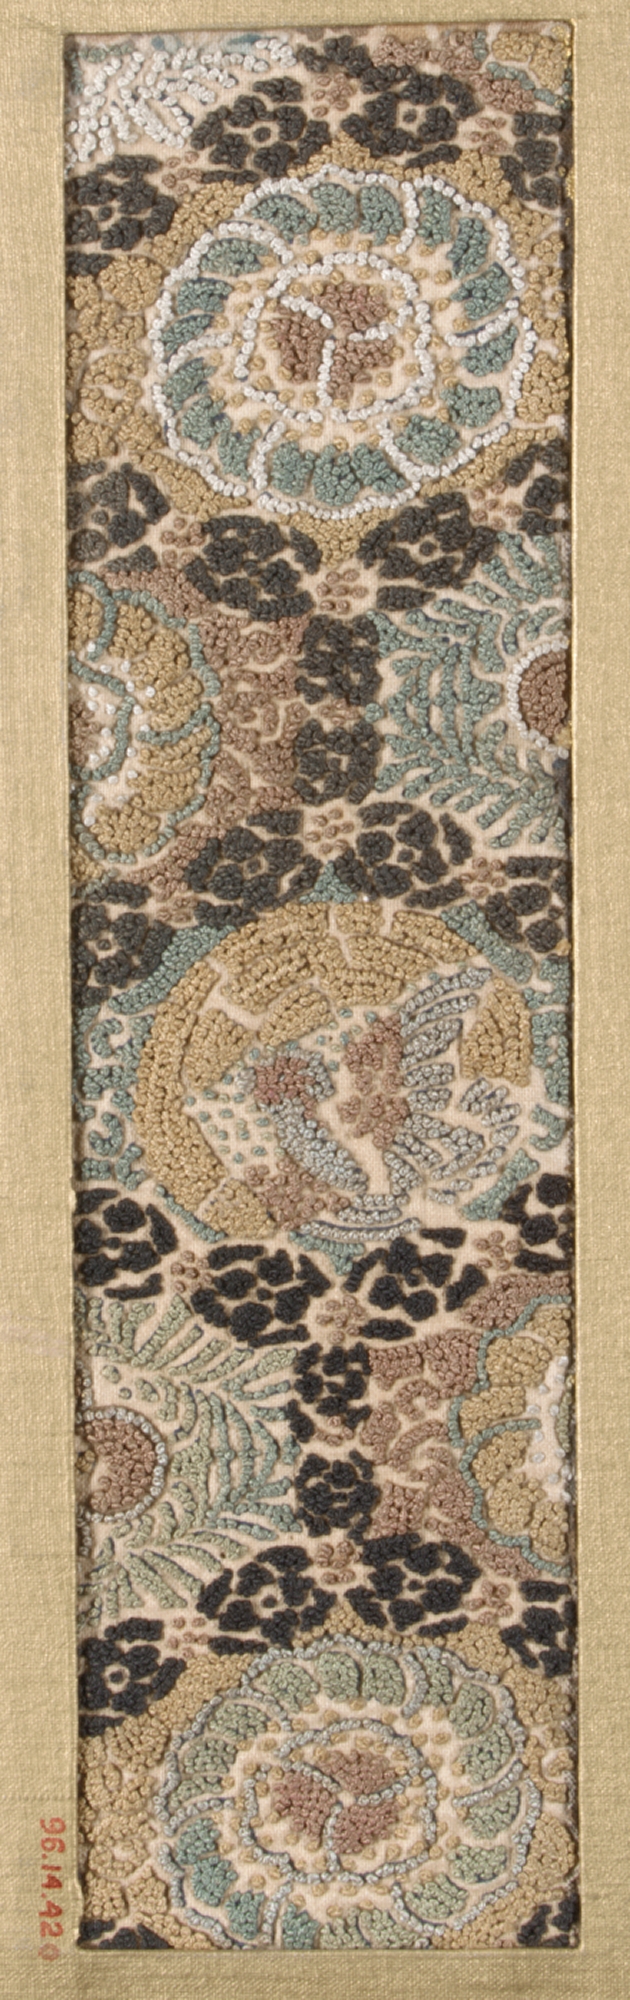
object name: piece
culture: japanese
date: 1701-1900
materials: silk